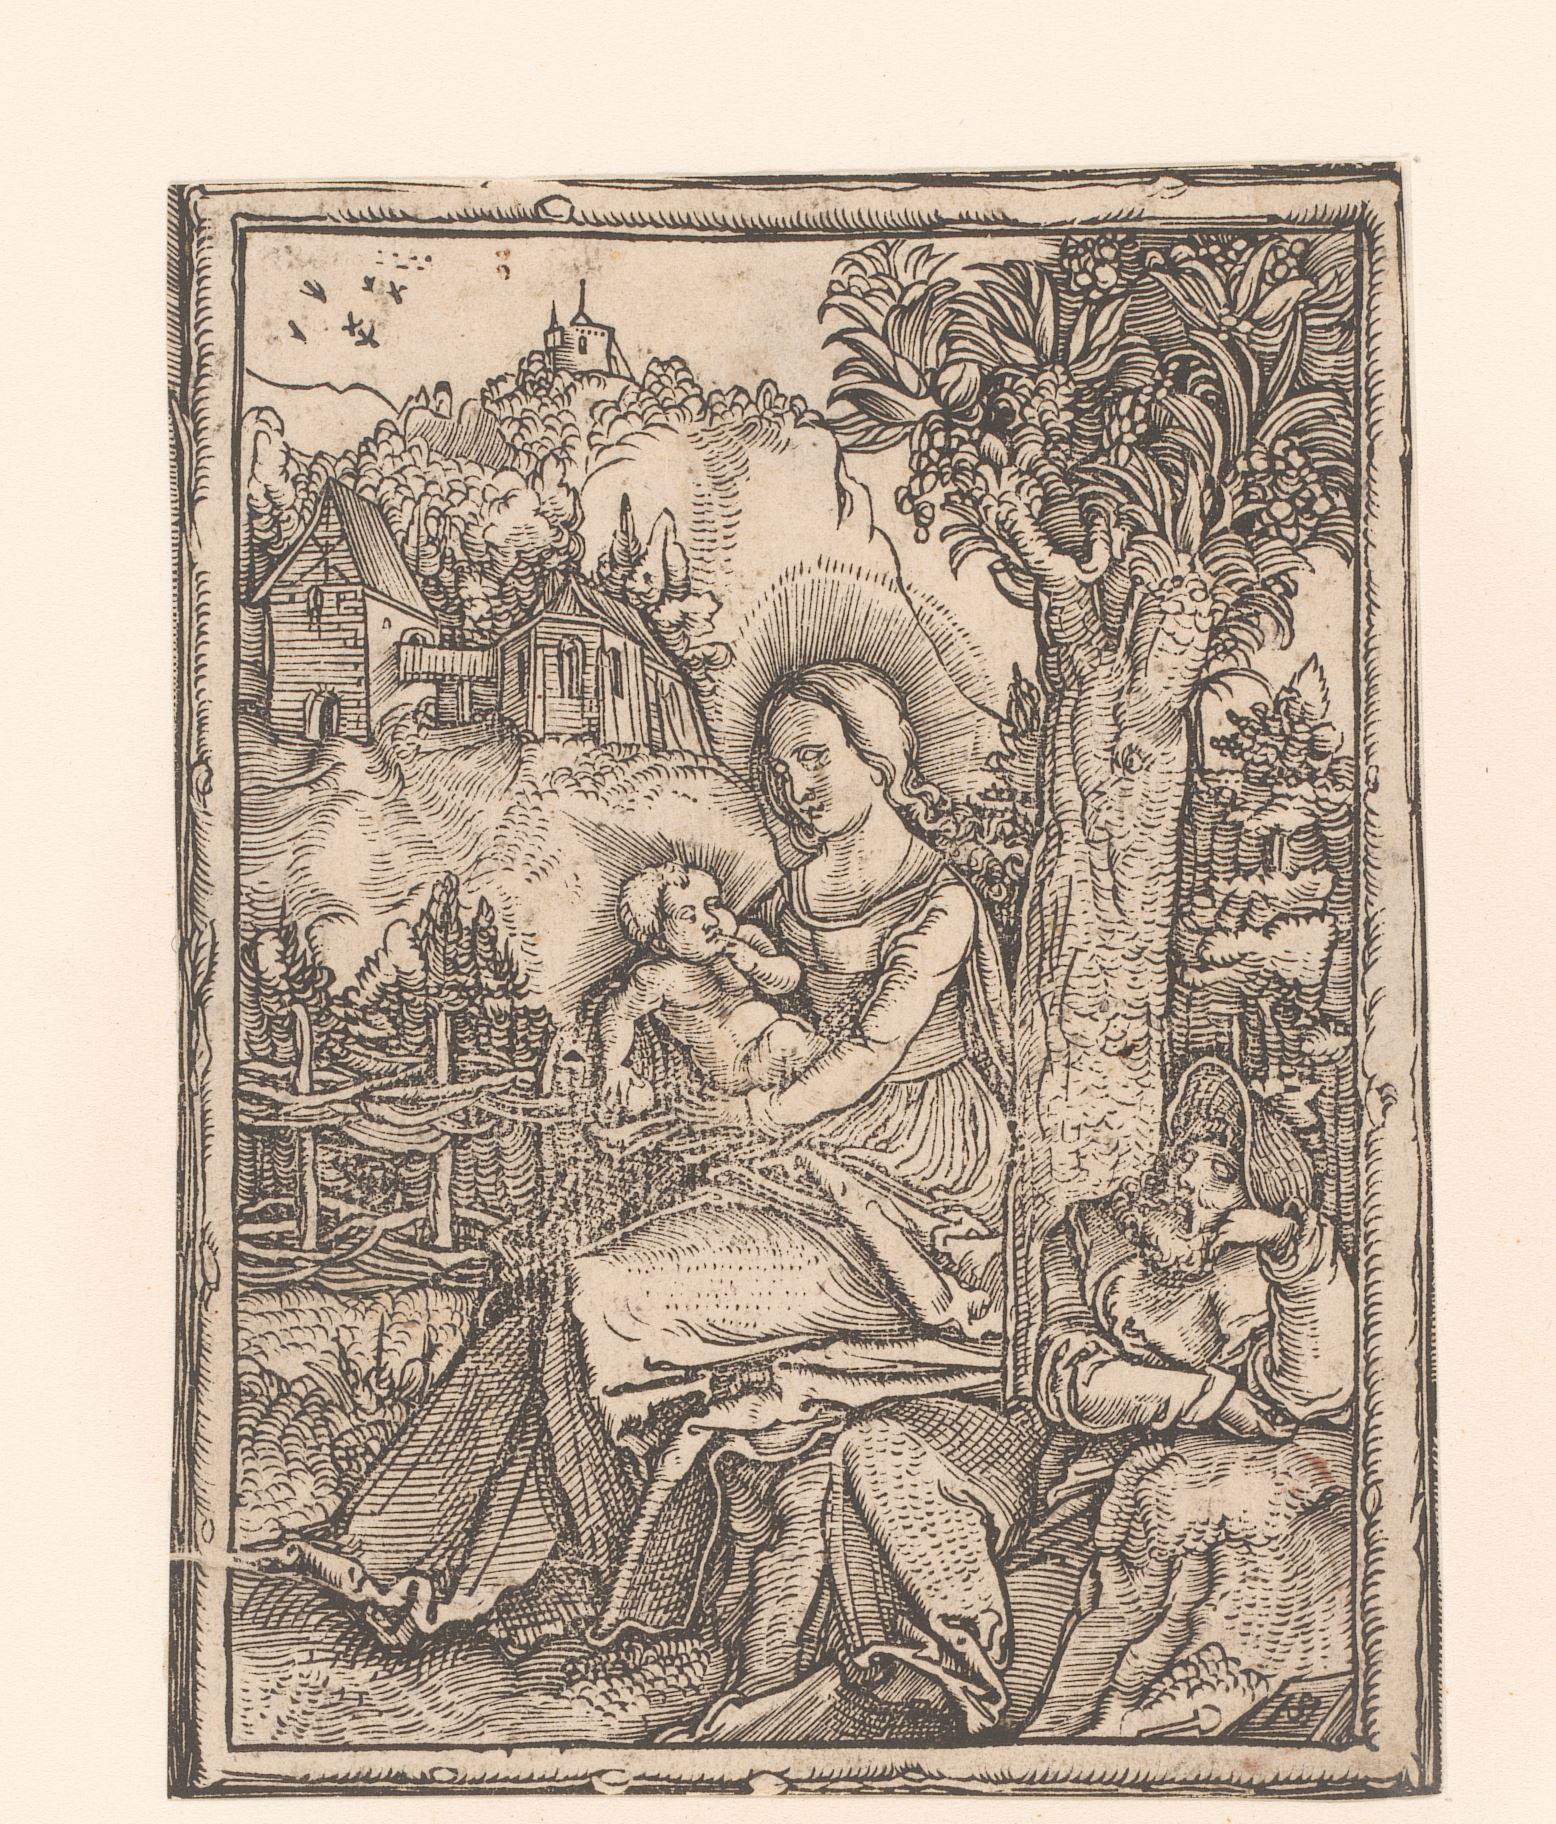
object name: print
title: Rest on the Flight into Egypt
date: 1515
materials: paper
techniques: woodcut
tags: rest on the flight into egypt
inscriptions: collector's mark: Lugt 240